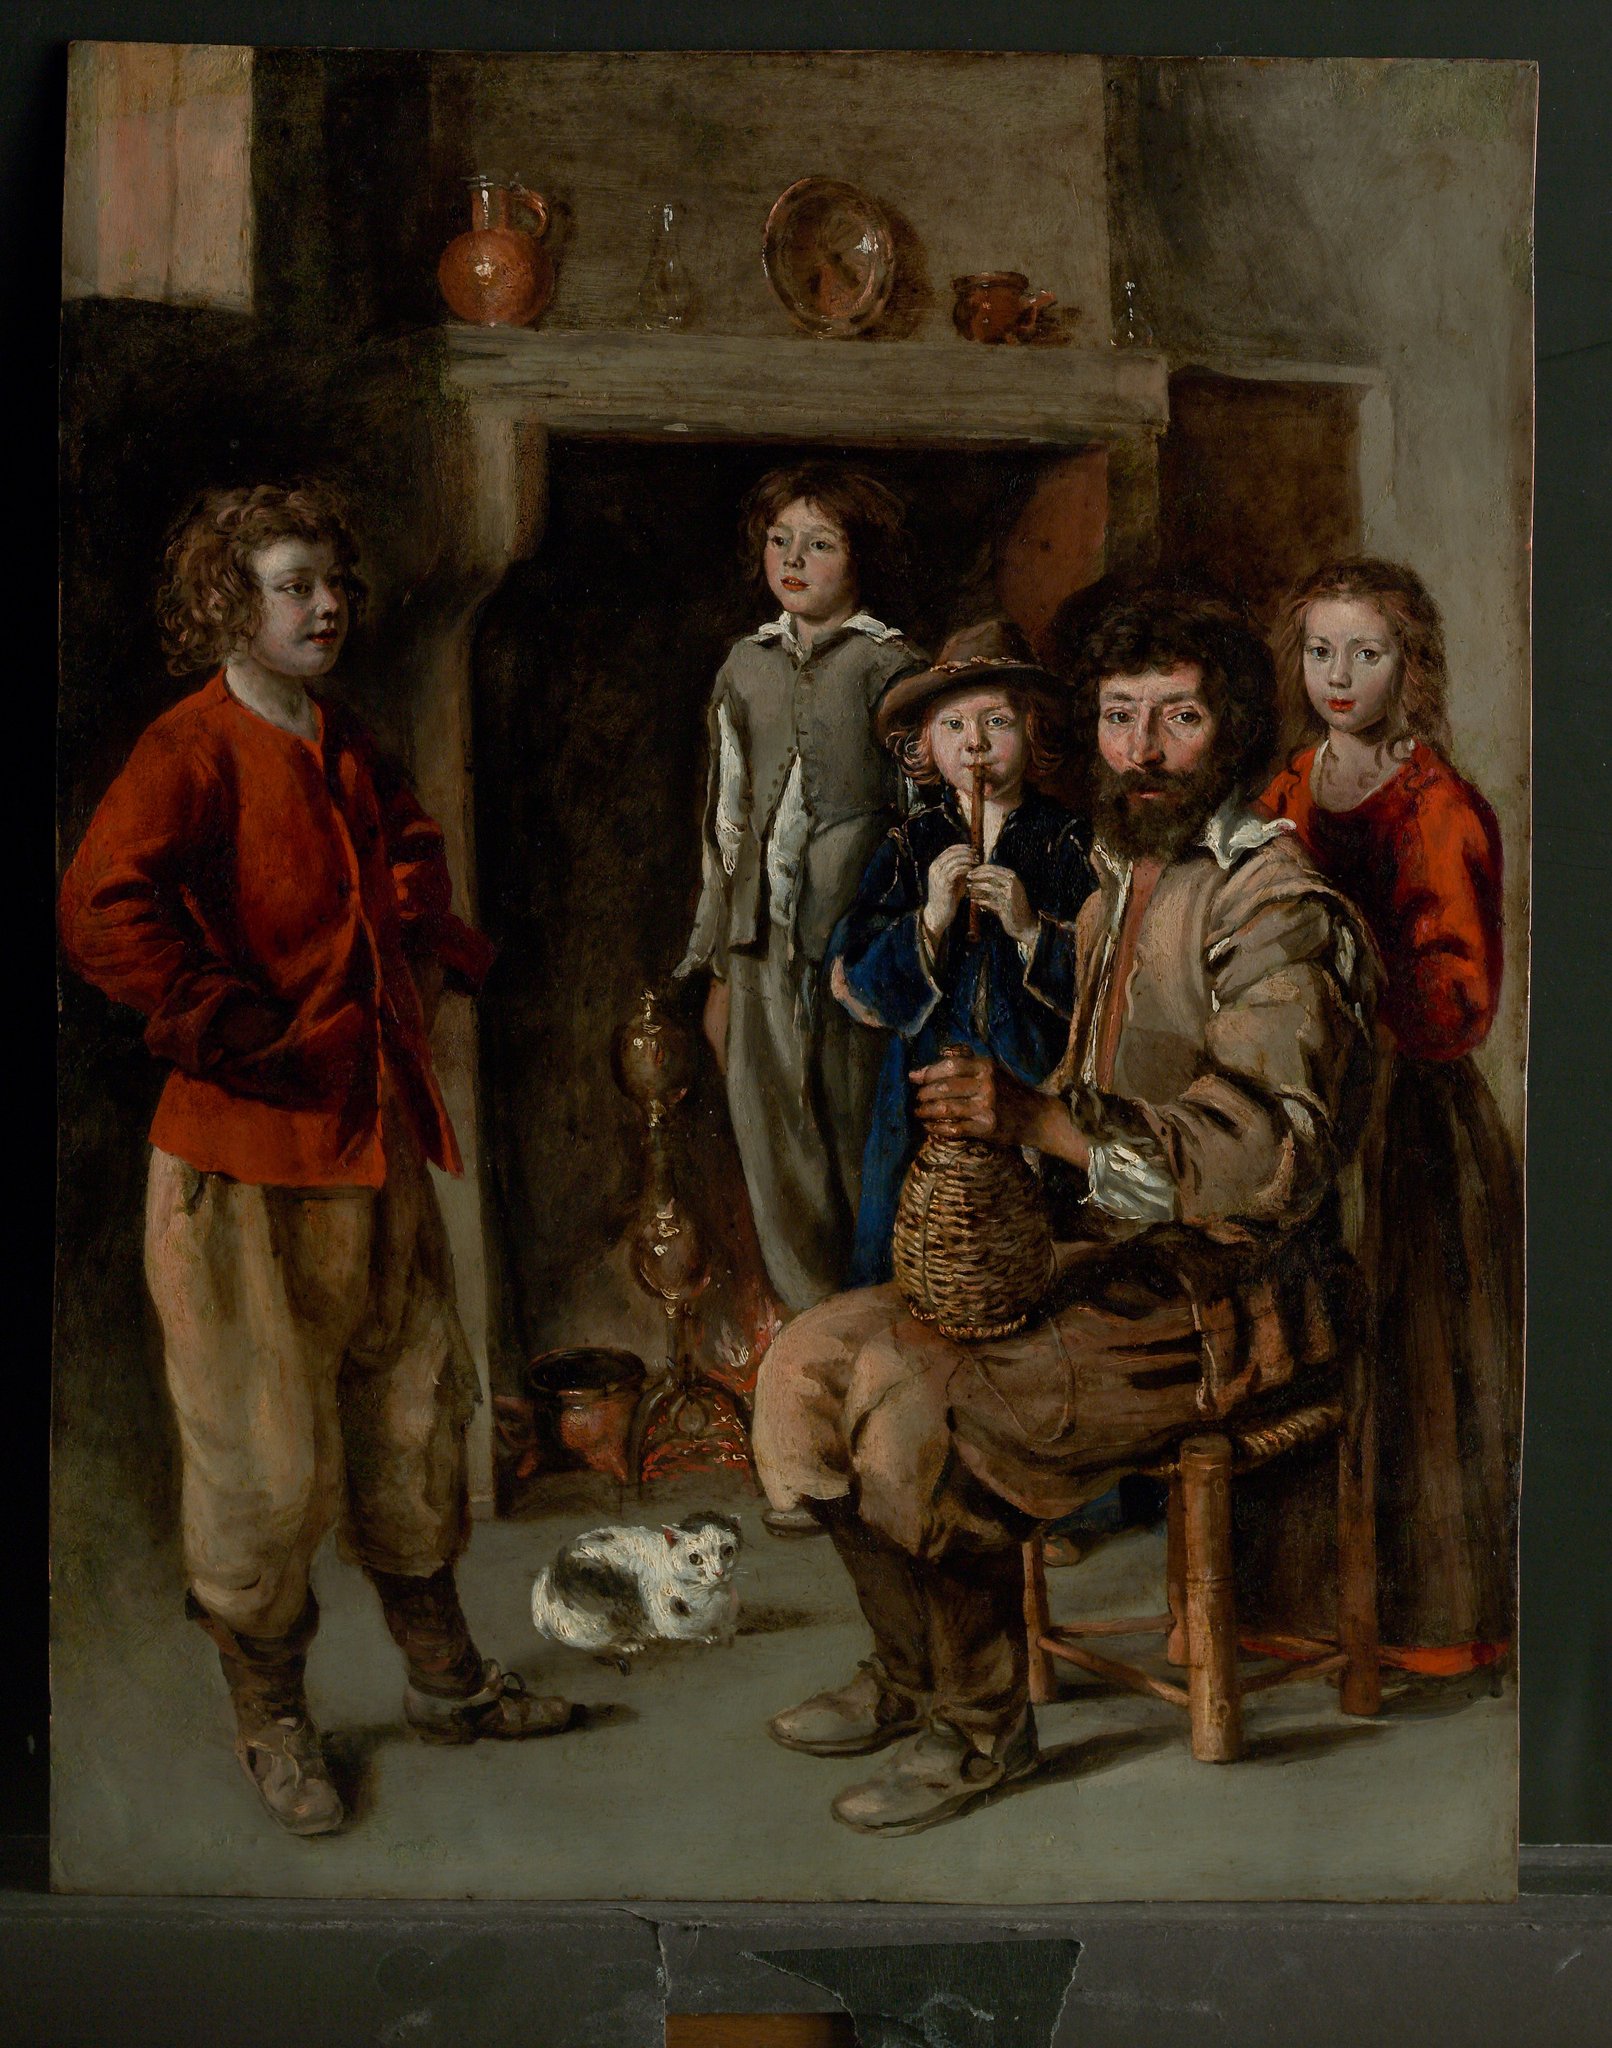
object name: painting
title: A Peasant Family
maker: antoine le nain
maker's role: artist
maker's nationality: french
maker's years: 1600-1648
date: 1640-1648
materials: copper, oil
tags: boys,girls,men,cats,family